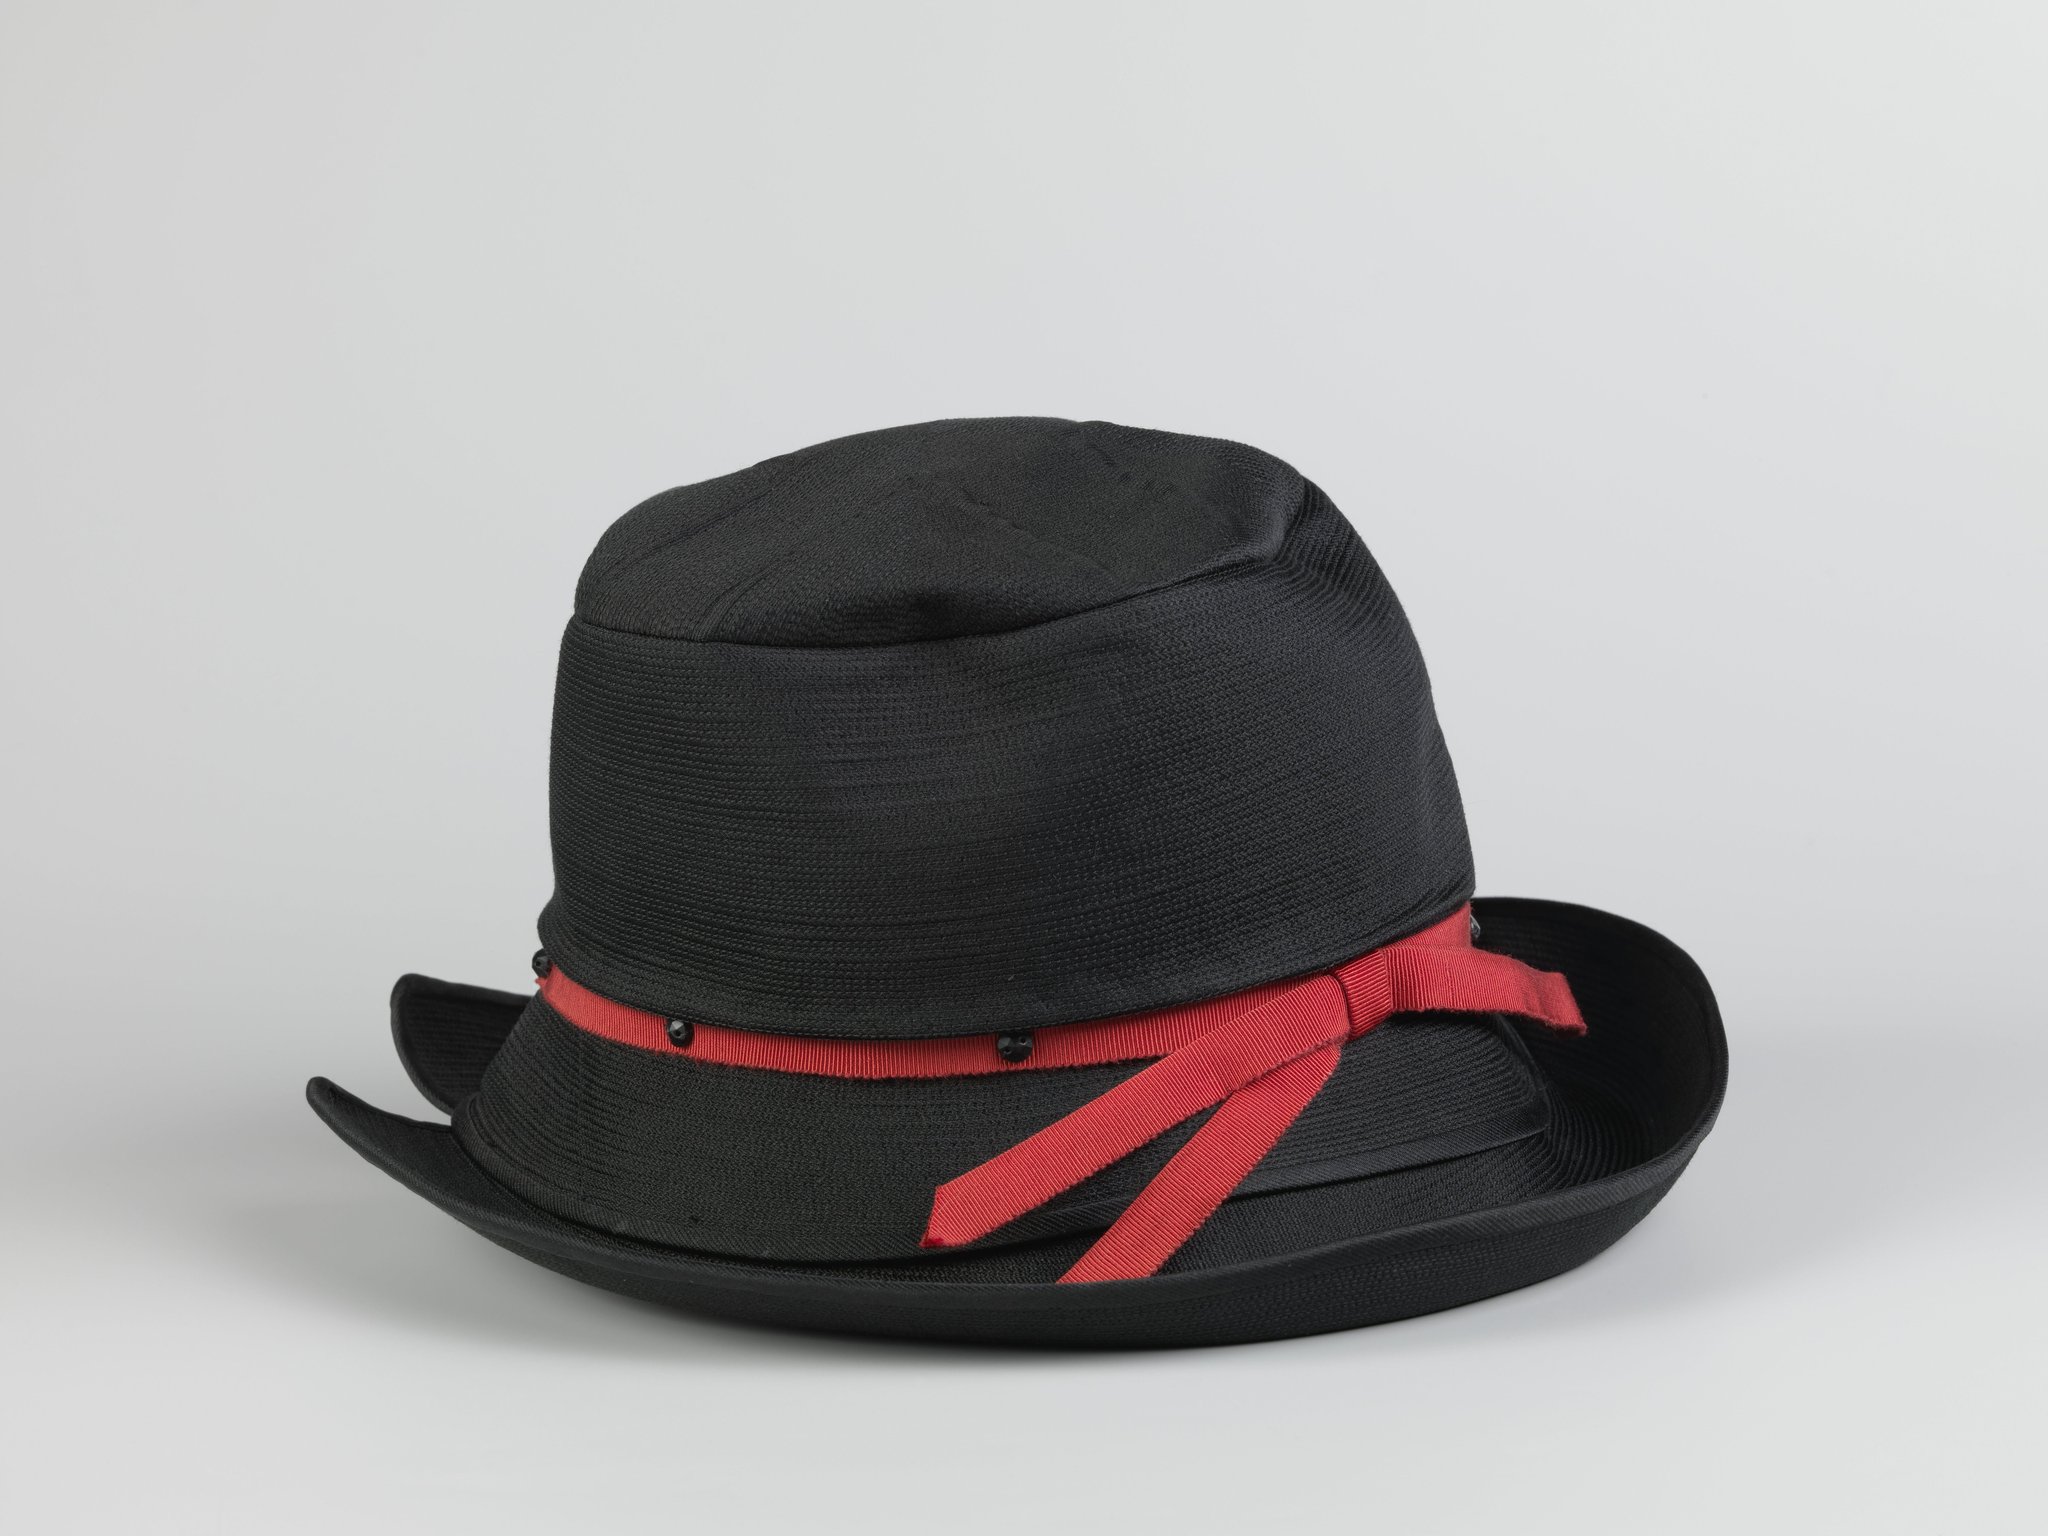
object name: hat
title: Hoed van zwart doorgestikt satijn versierd met een rood ripslint en zwarte gitten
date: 1960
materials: jet, textile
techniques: quilting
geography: amsterdam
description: Hoed van zwart doorgestikt satijn versierd met een rood ripslint en zwarte gitten. Hoge bol, recht van boven. Deze bol loopt door over de brede rand, die achter in de nek niet sluit. Gevoerd met zwart satijnen voeringsstof, deze is op kleine afstanden doorgestikt. Boven op de bol vormt dit stiksel een breed kruis. Op het rode ripslint, dat aan de zijkanten gestrikt is, zijn op gelijke afstand ronde, zwarte gitten genaaid. Samen met hoedendoos van La femme chic Amsterdam.